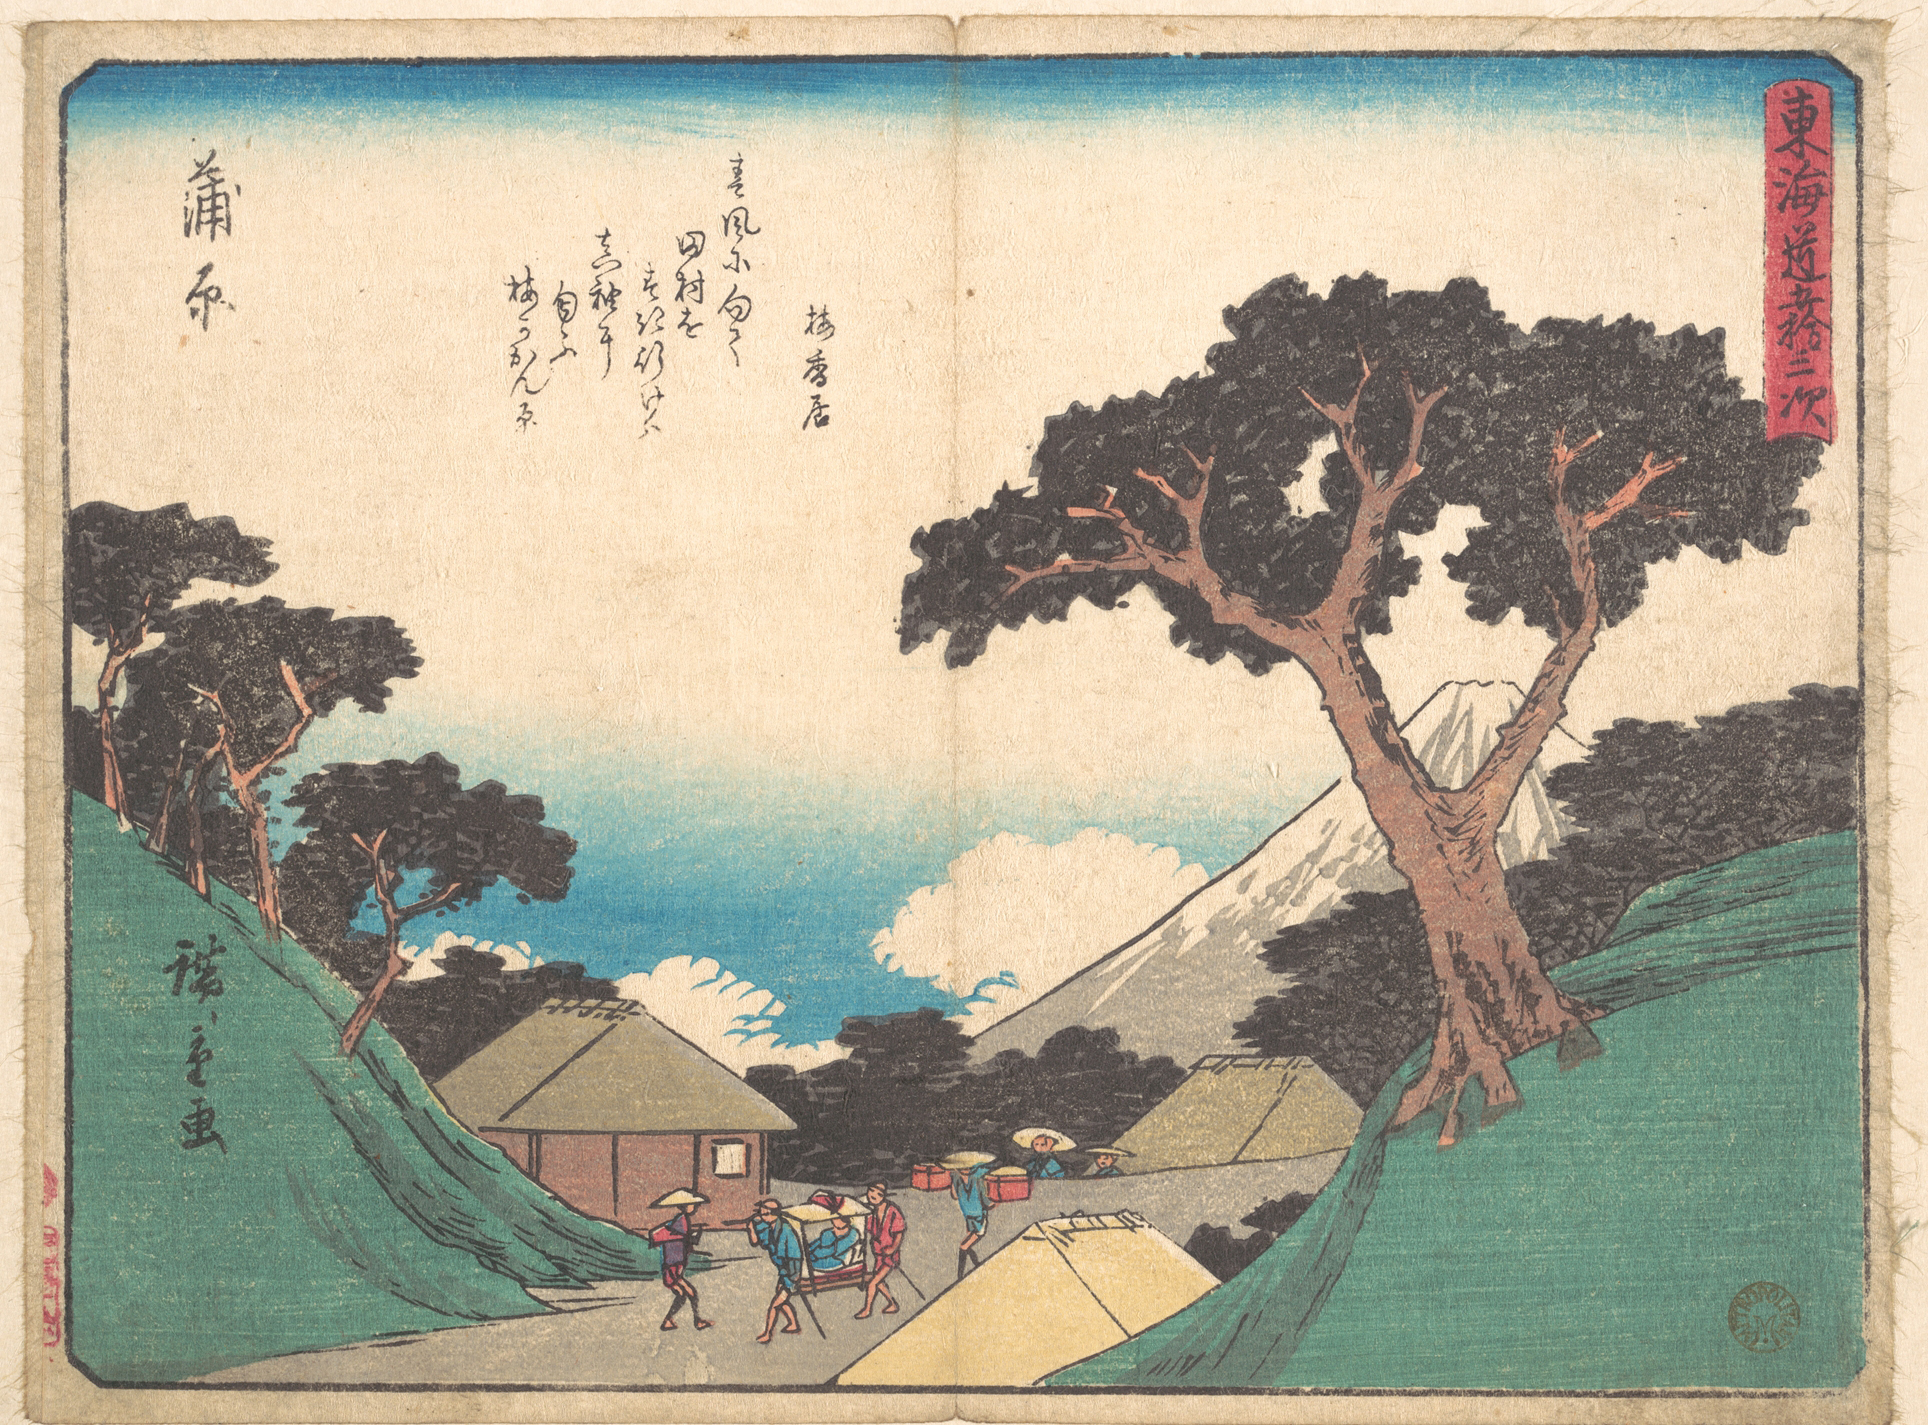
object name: woodblock print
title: Kambara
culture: japanese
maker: utagawa hiroshige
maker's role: artist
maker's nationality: japanese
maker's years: 1797-1858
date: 1838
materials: ink, paper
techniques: woodblock print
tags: human figures,houses,mountains,trees